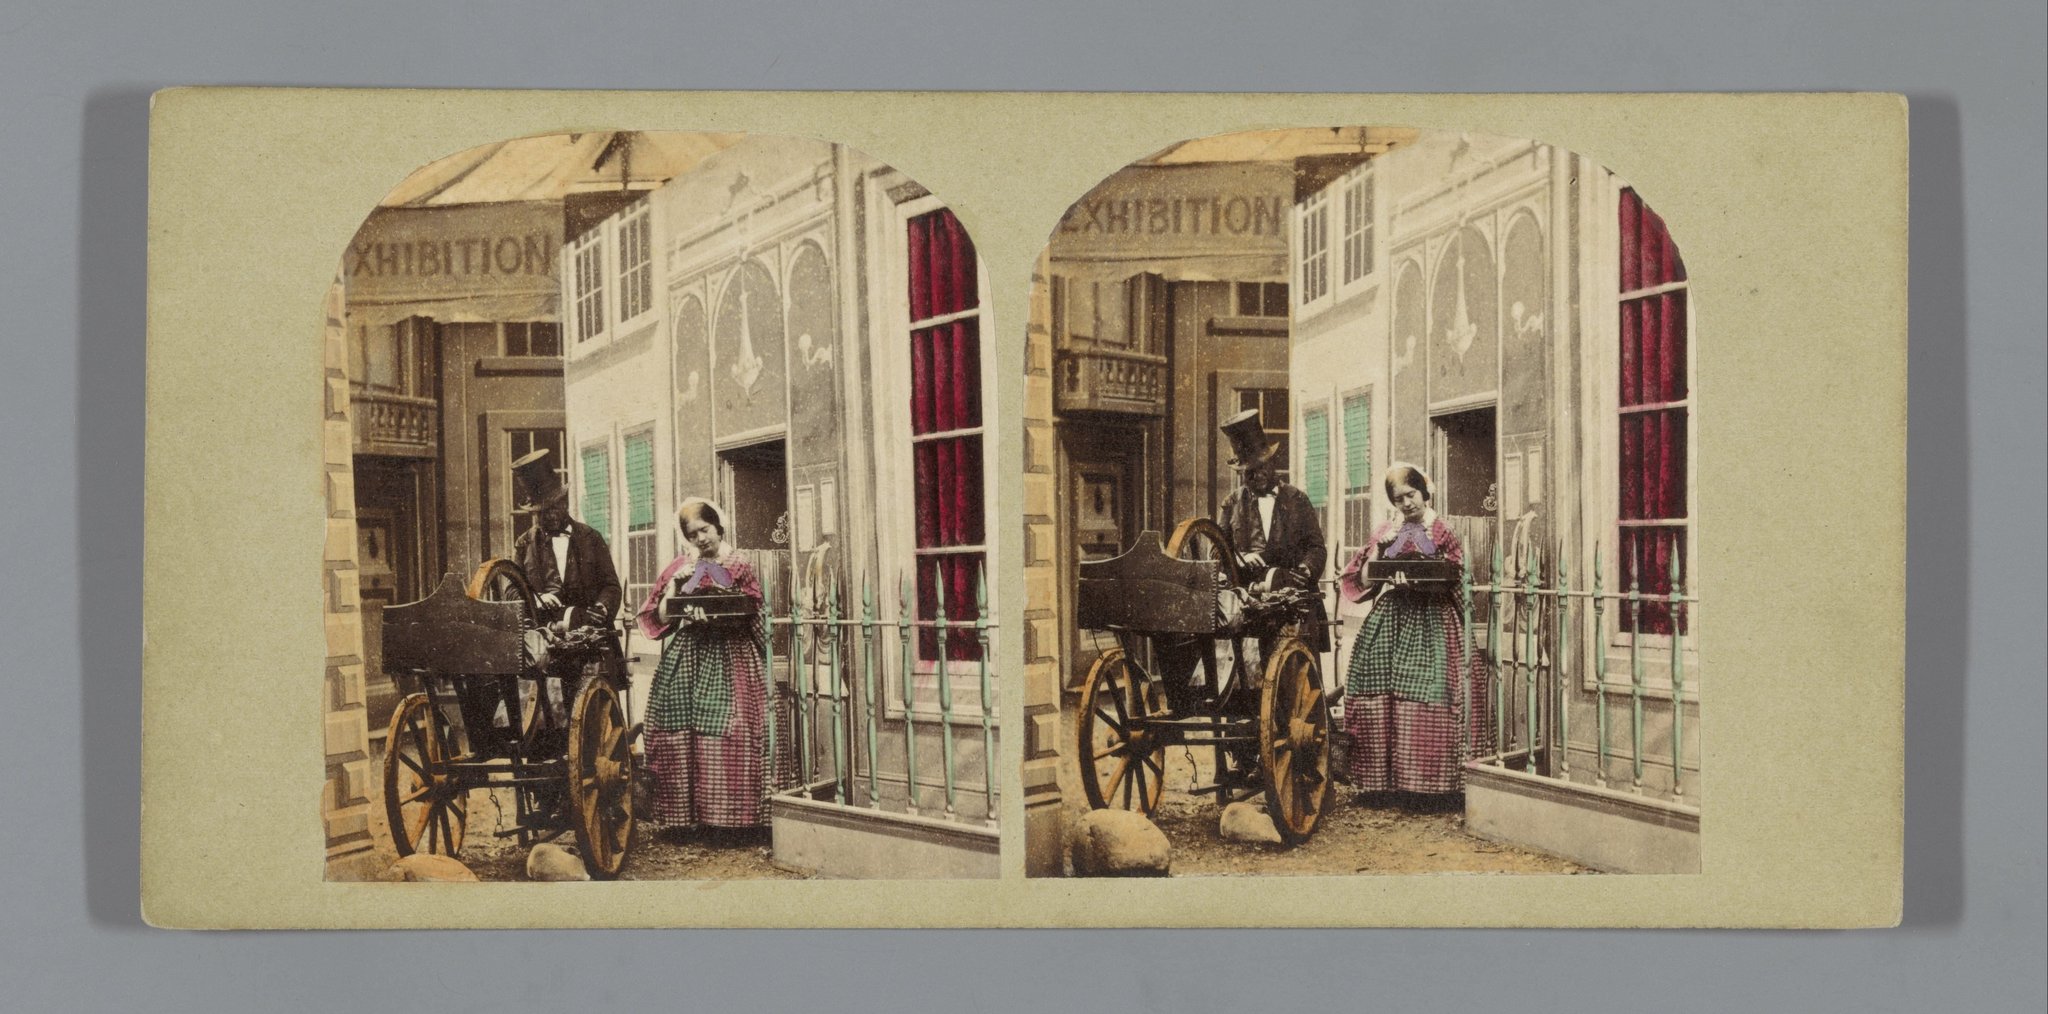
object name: stereograph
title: Vrouw op straat naast een scharensliep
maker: Anonymous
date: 1852-1863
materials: cardboard, paper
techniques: albumen print, hand coloring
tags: tools, aids, implements ~ crafts and industries: grindstone, tools, aids, implements ~ crafts and industries: knife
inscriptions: stamp: ‘J. C. MEERBURG,/ LEIJDEN’, number: ‘12’